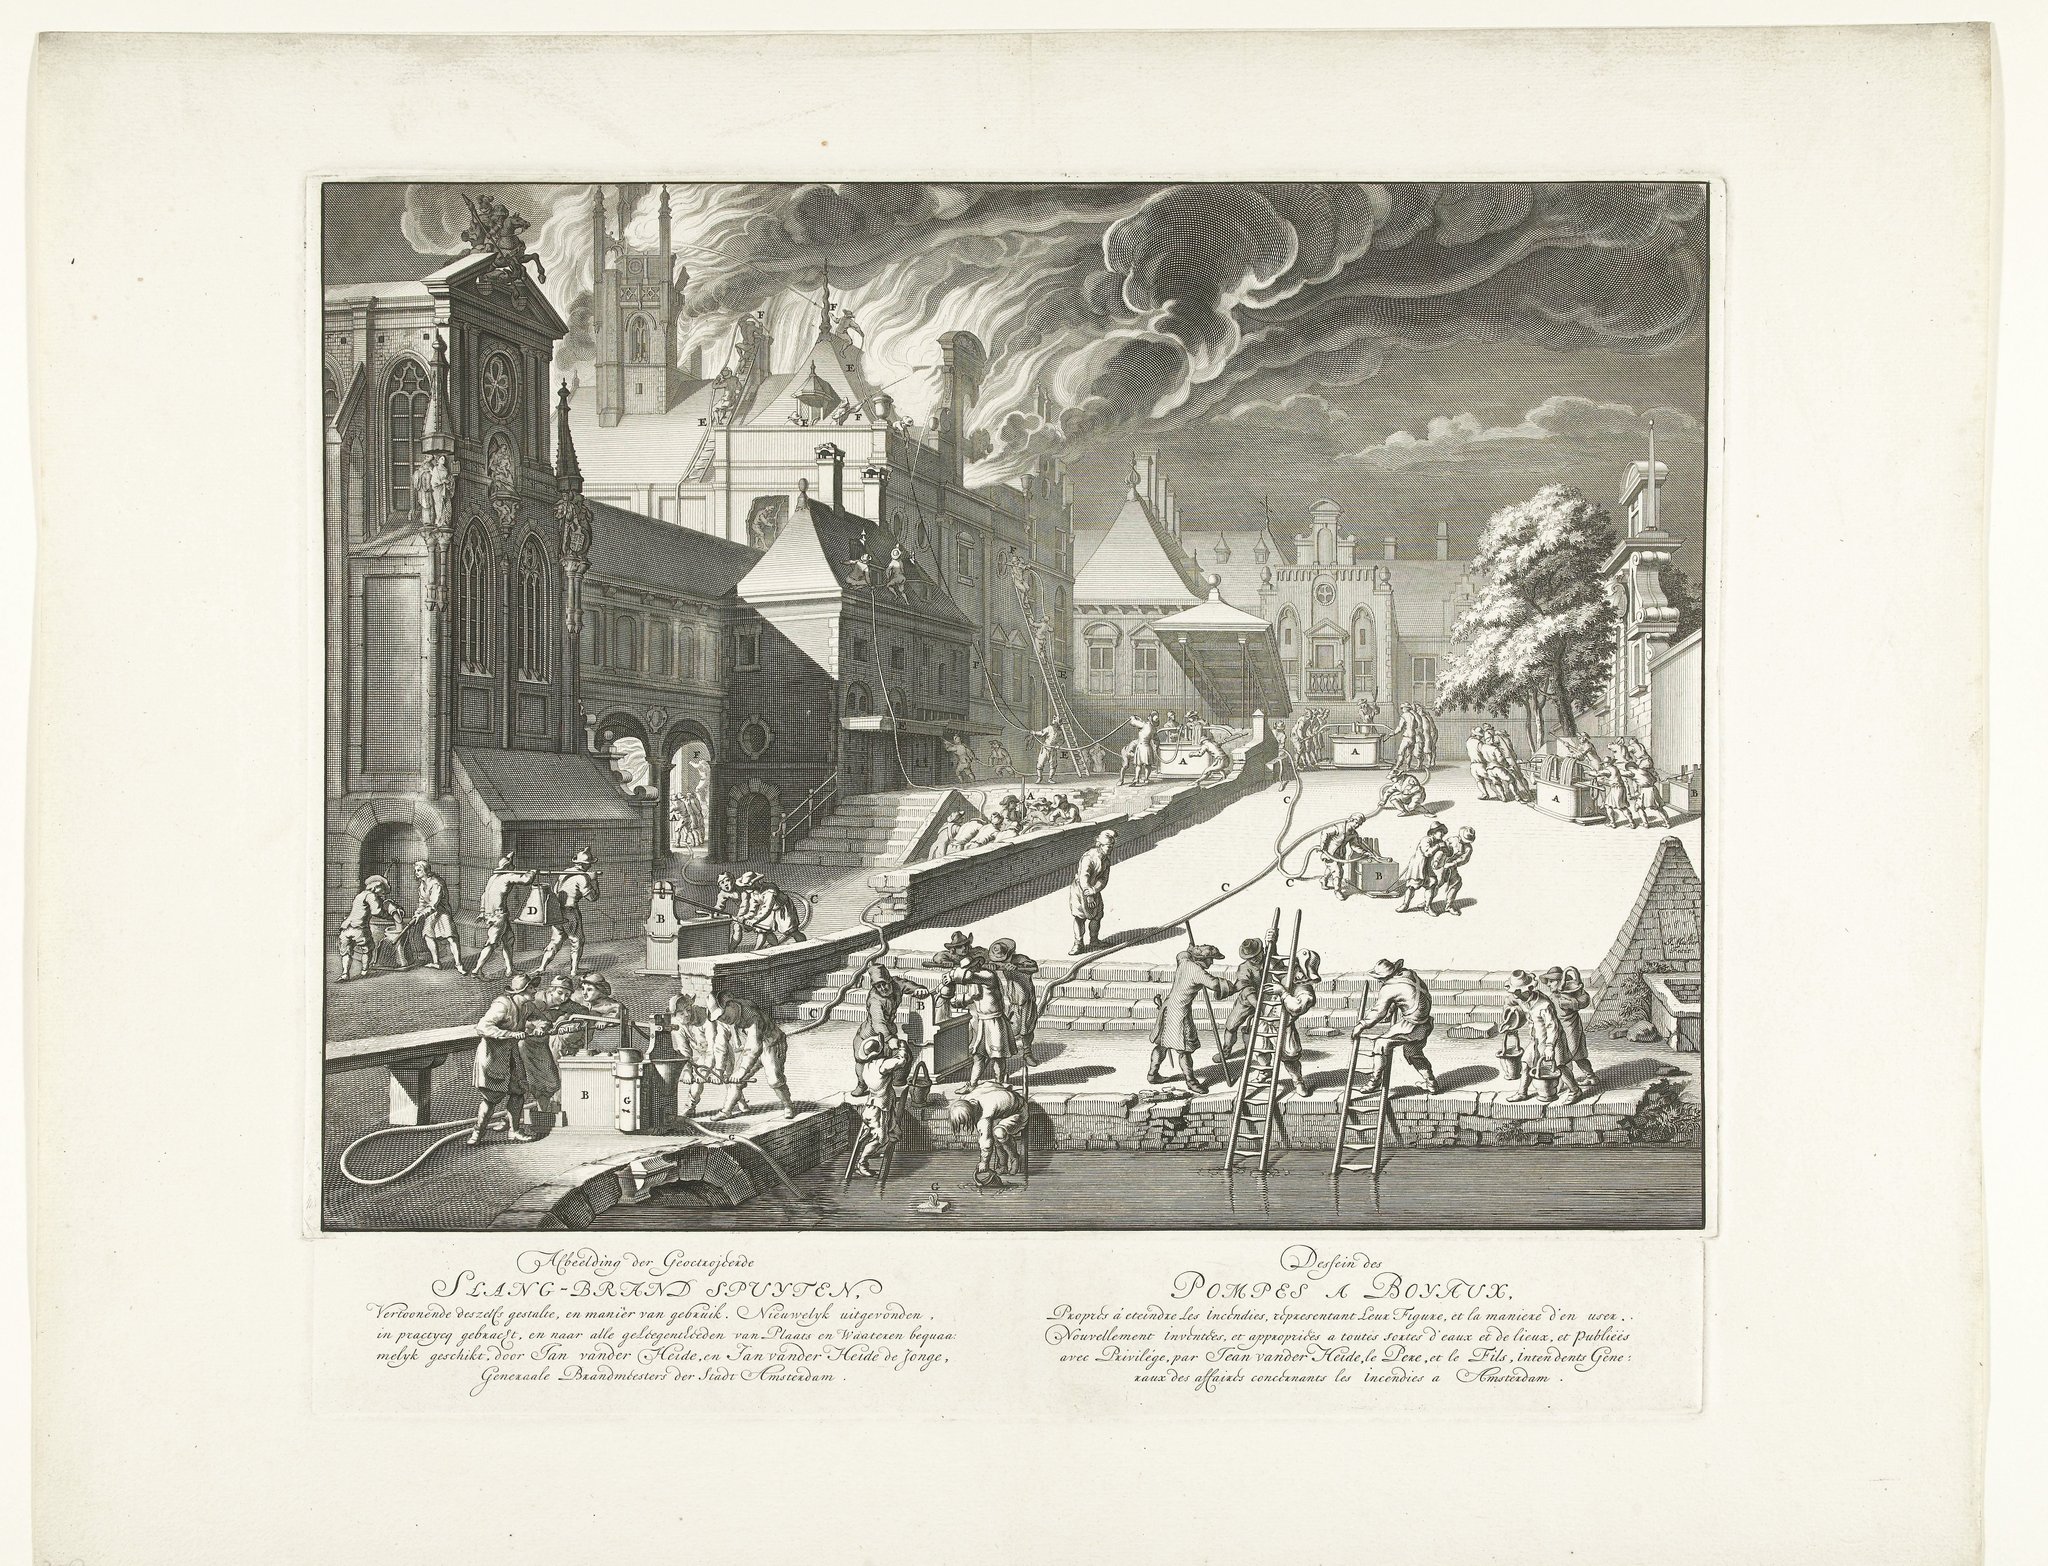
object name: print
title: Gebruik van de nieuwe brandspuitslangen, 1677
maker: joseph mulder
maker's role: print maker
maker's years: 1658-1718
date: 1677-1718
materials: paper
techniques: etching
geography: northern netherlands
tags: painter, print maker, draughtsman, jan van der heyden, amsterdam, jan van der heyden (de jonge), fire-extinguishing equipment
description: Blad met een grote voorstelling van de toepassing van de nieuwe slangbrandspuiten van Jan van der Heyden en Jan van der Heyden de Jonge bij het blussen van een brand in een kerk of paleis in een imaginaire stad. Onder de plaat zijn op een aparte plaat de titels in het Nederlands en Frans gedrukt. Behoort tot de bijprenten bij het Brandspuitenboek van Jan van der Heyden.